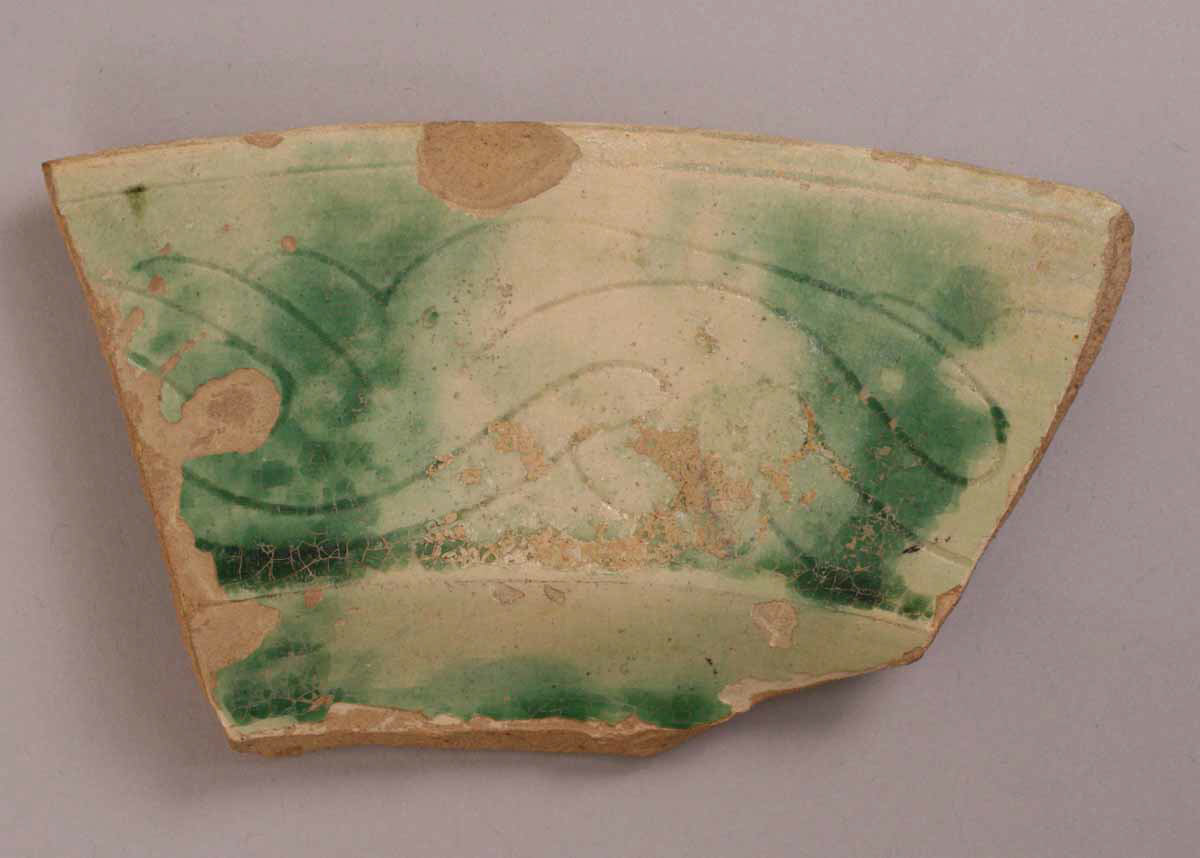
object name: fragment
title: Two Fragments of Splashed Sgraffito Ware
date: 801-900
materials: earthenware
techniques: glazing, incising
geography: iraq